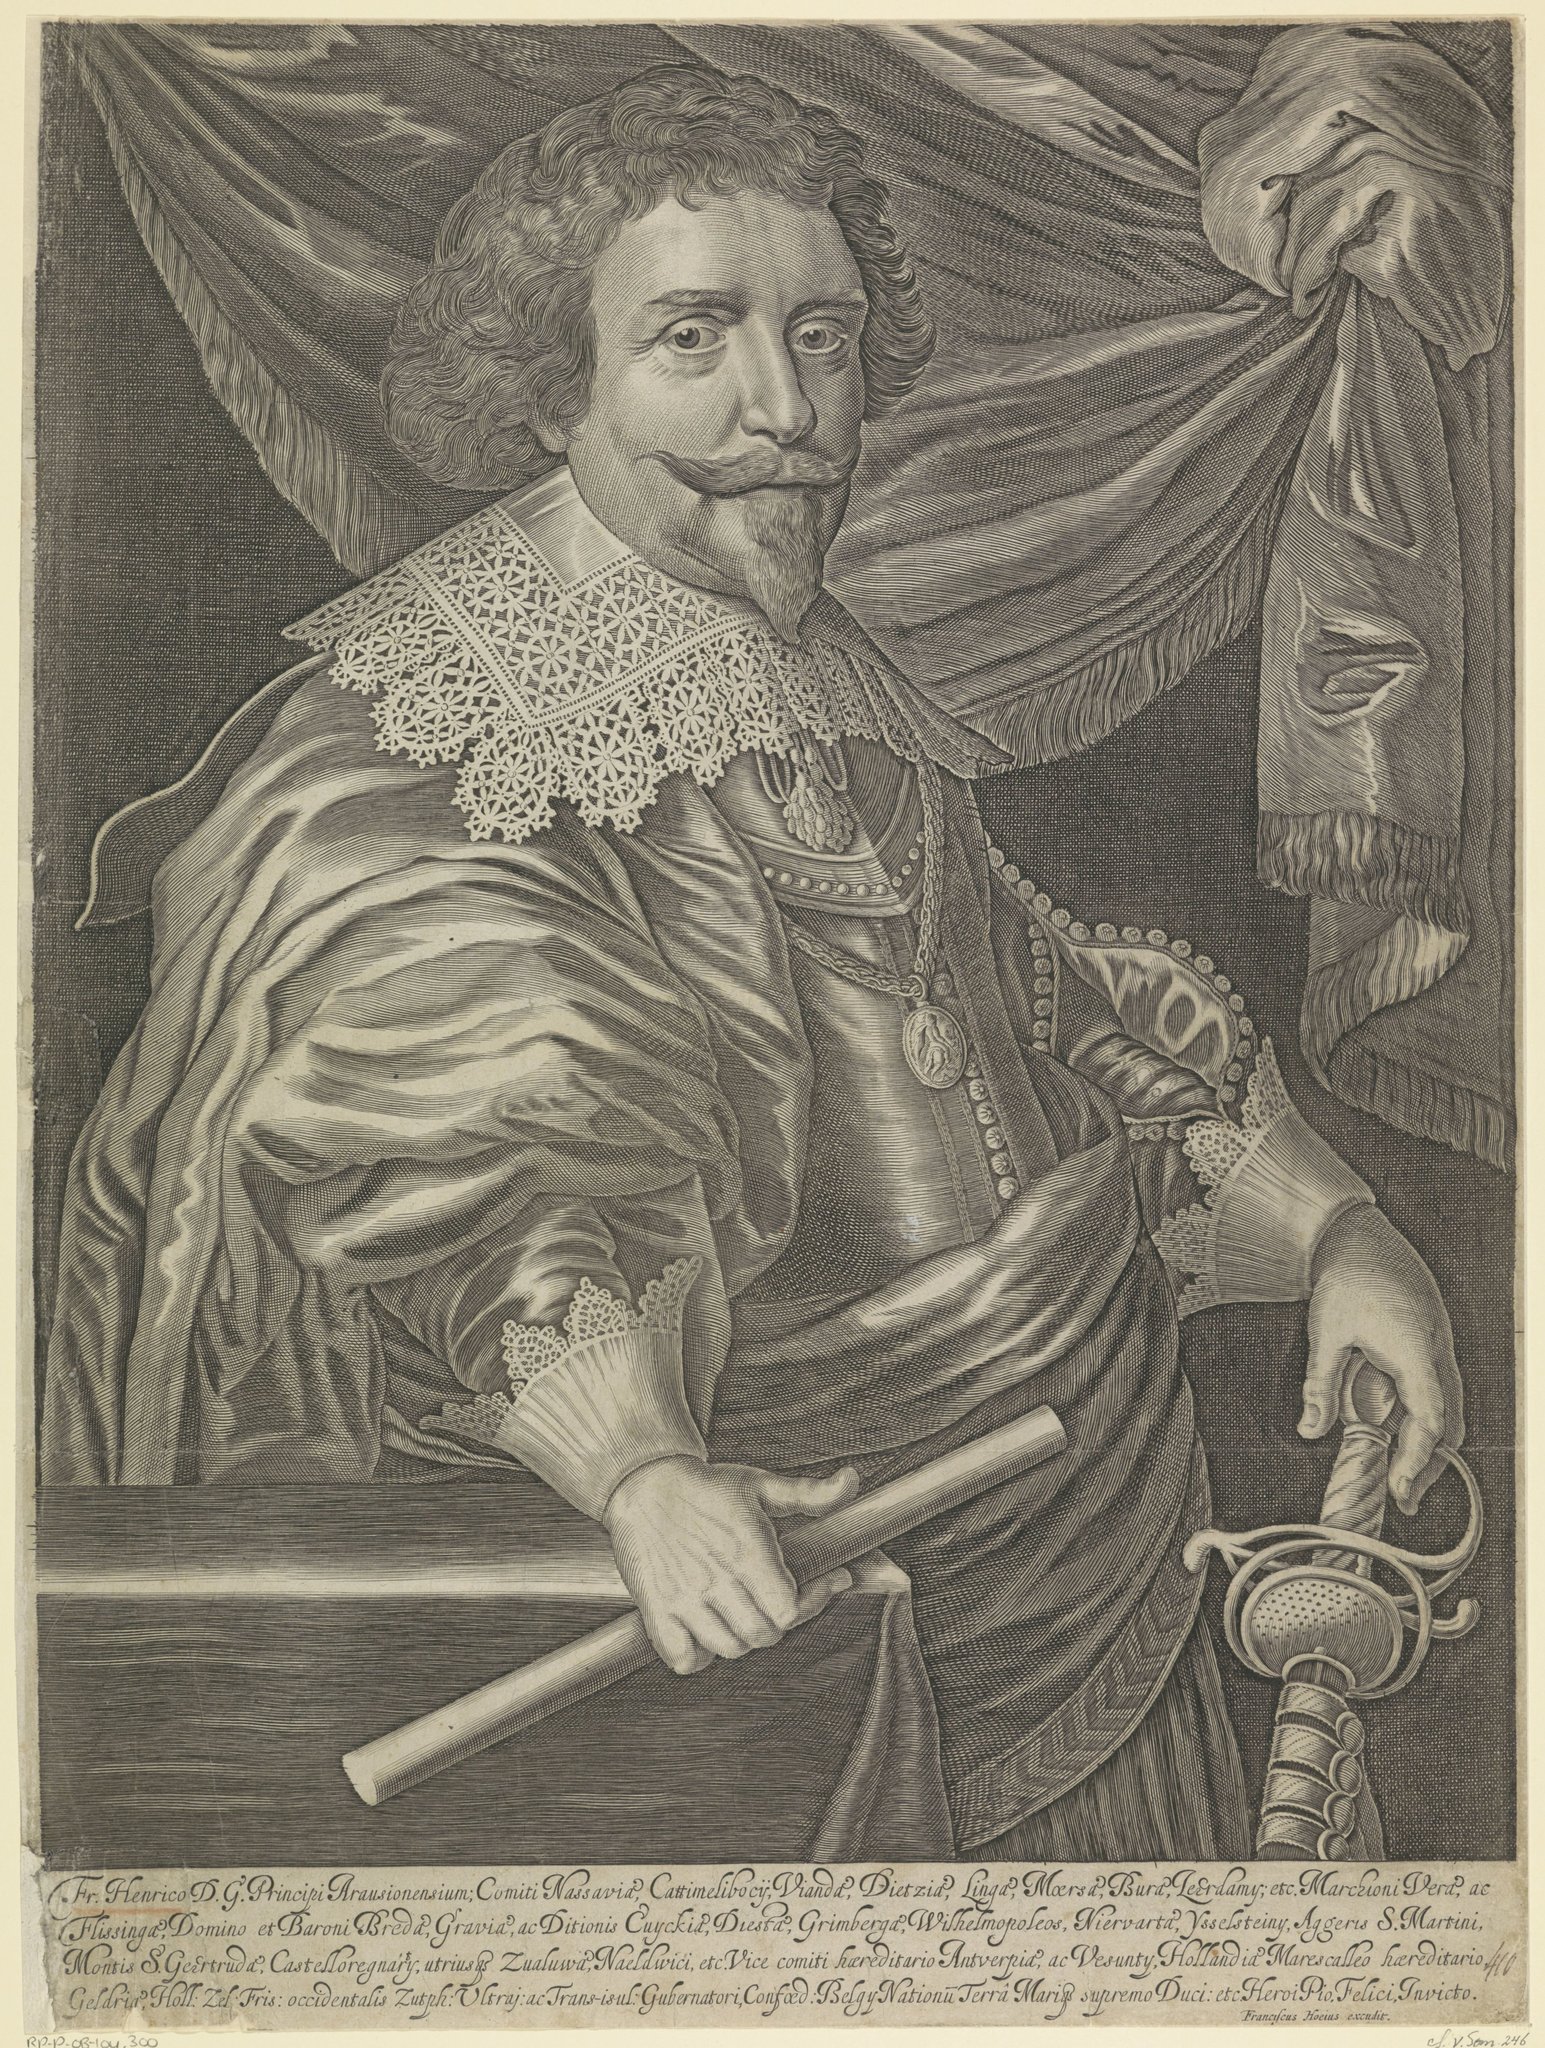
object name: print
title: Portret van Frederik Hendrik, prins van Oranje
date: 1627-1636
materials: paper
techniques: engraving, etching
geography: amsterdam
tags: delft, frederick henry (prince of orange), knighthood order (garter) - insignia of a knighthood order, e.g.: badge, chain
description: De hier vermelde titel verwijst naar de hoogst verkregen titel van de geportretteerde, niet per se naar de titel die de geportretteerde op deze voorstelling draagt.